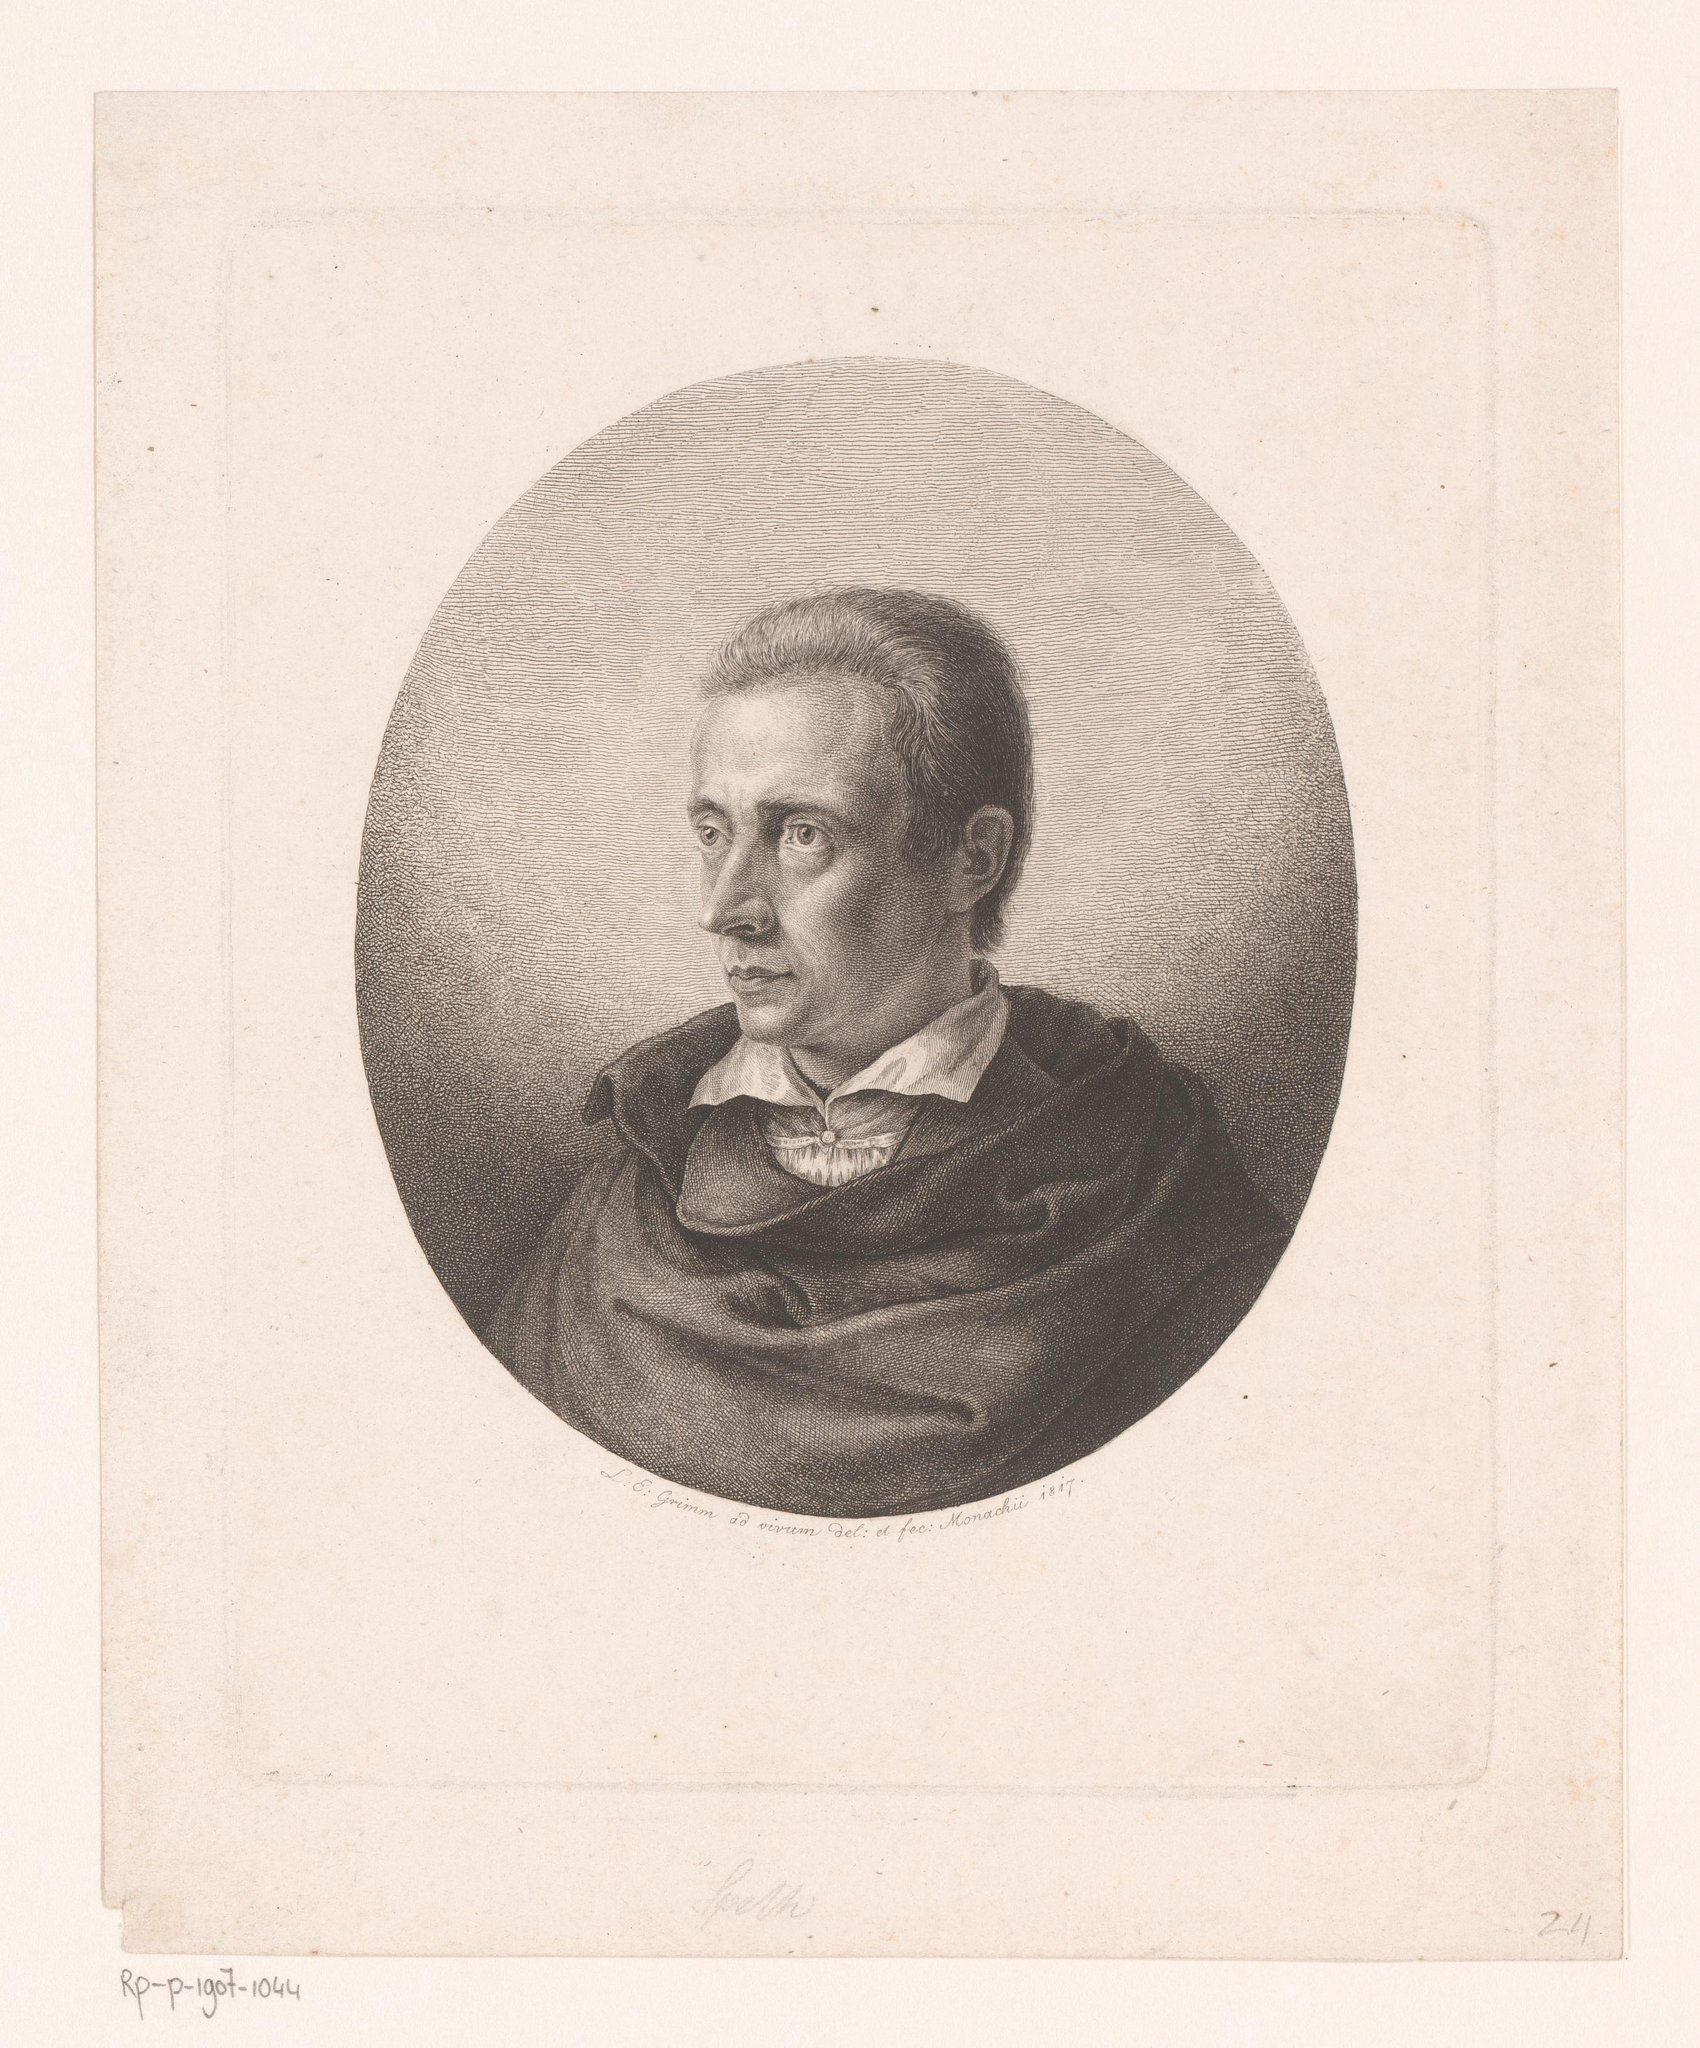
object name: print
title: Portret van Balthasar Speth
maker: ludwig emil grimm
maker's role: print maker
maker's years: 1790-1863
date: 1817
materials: paper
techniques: etching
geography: munich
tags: historical persons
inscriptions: collector's mark: Lugt 2228